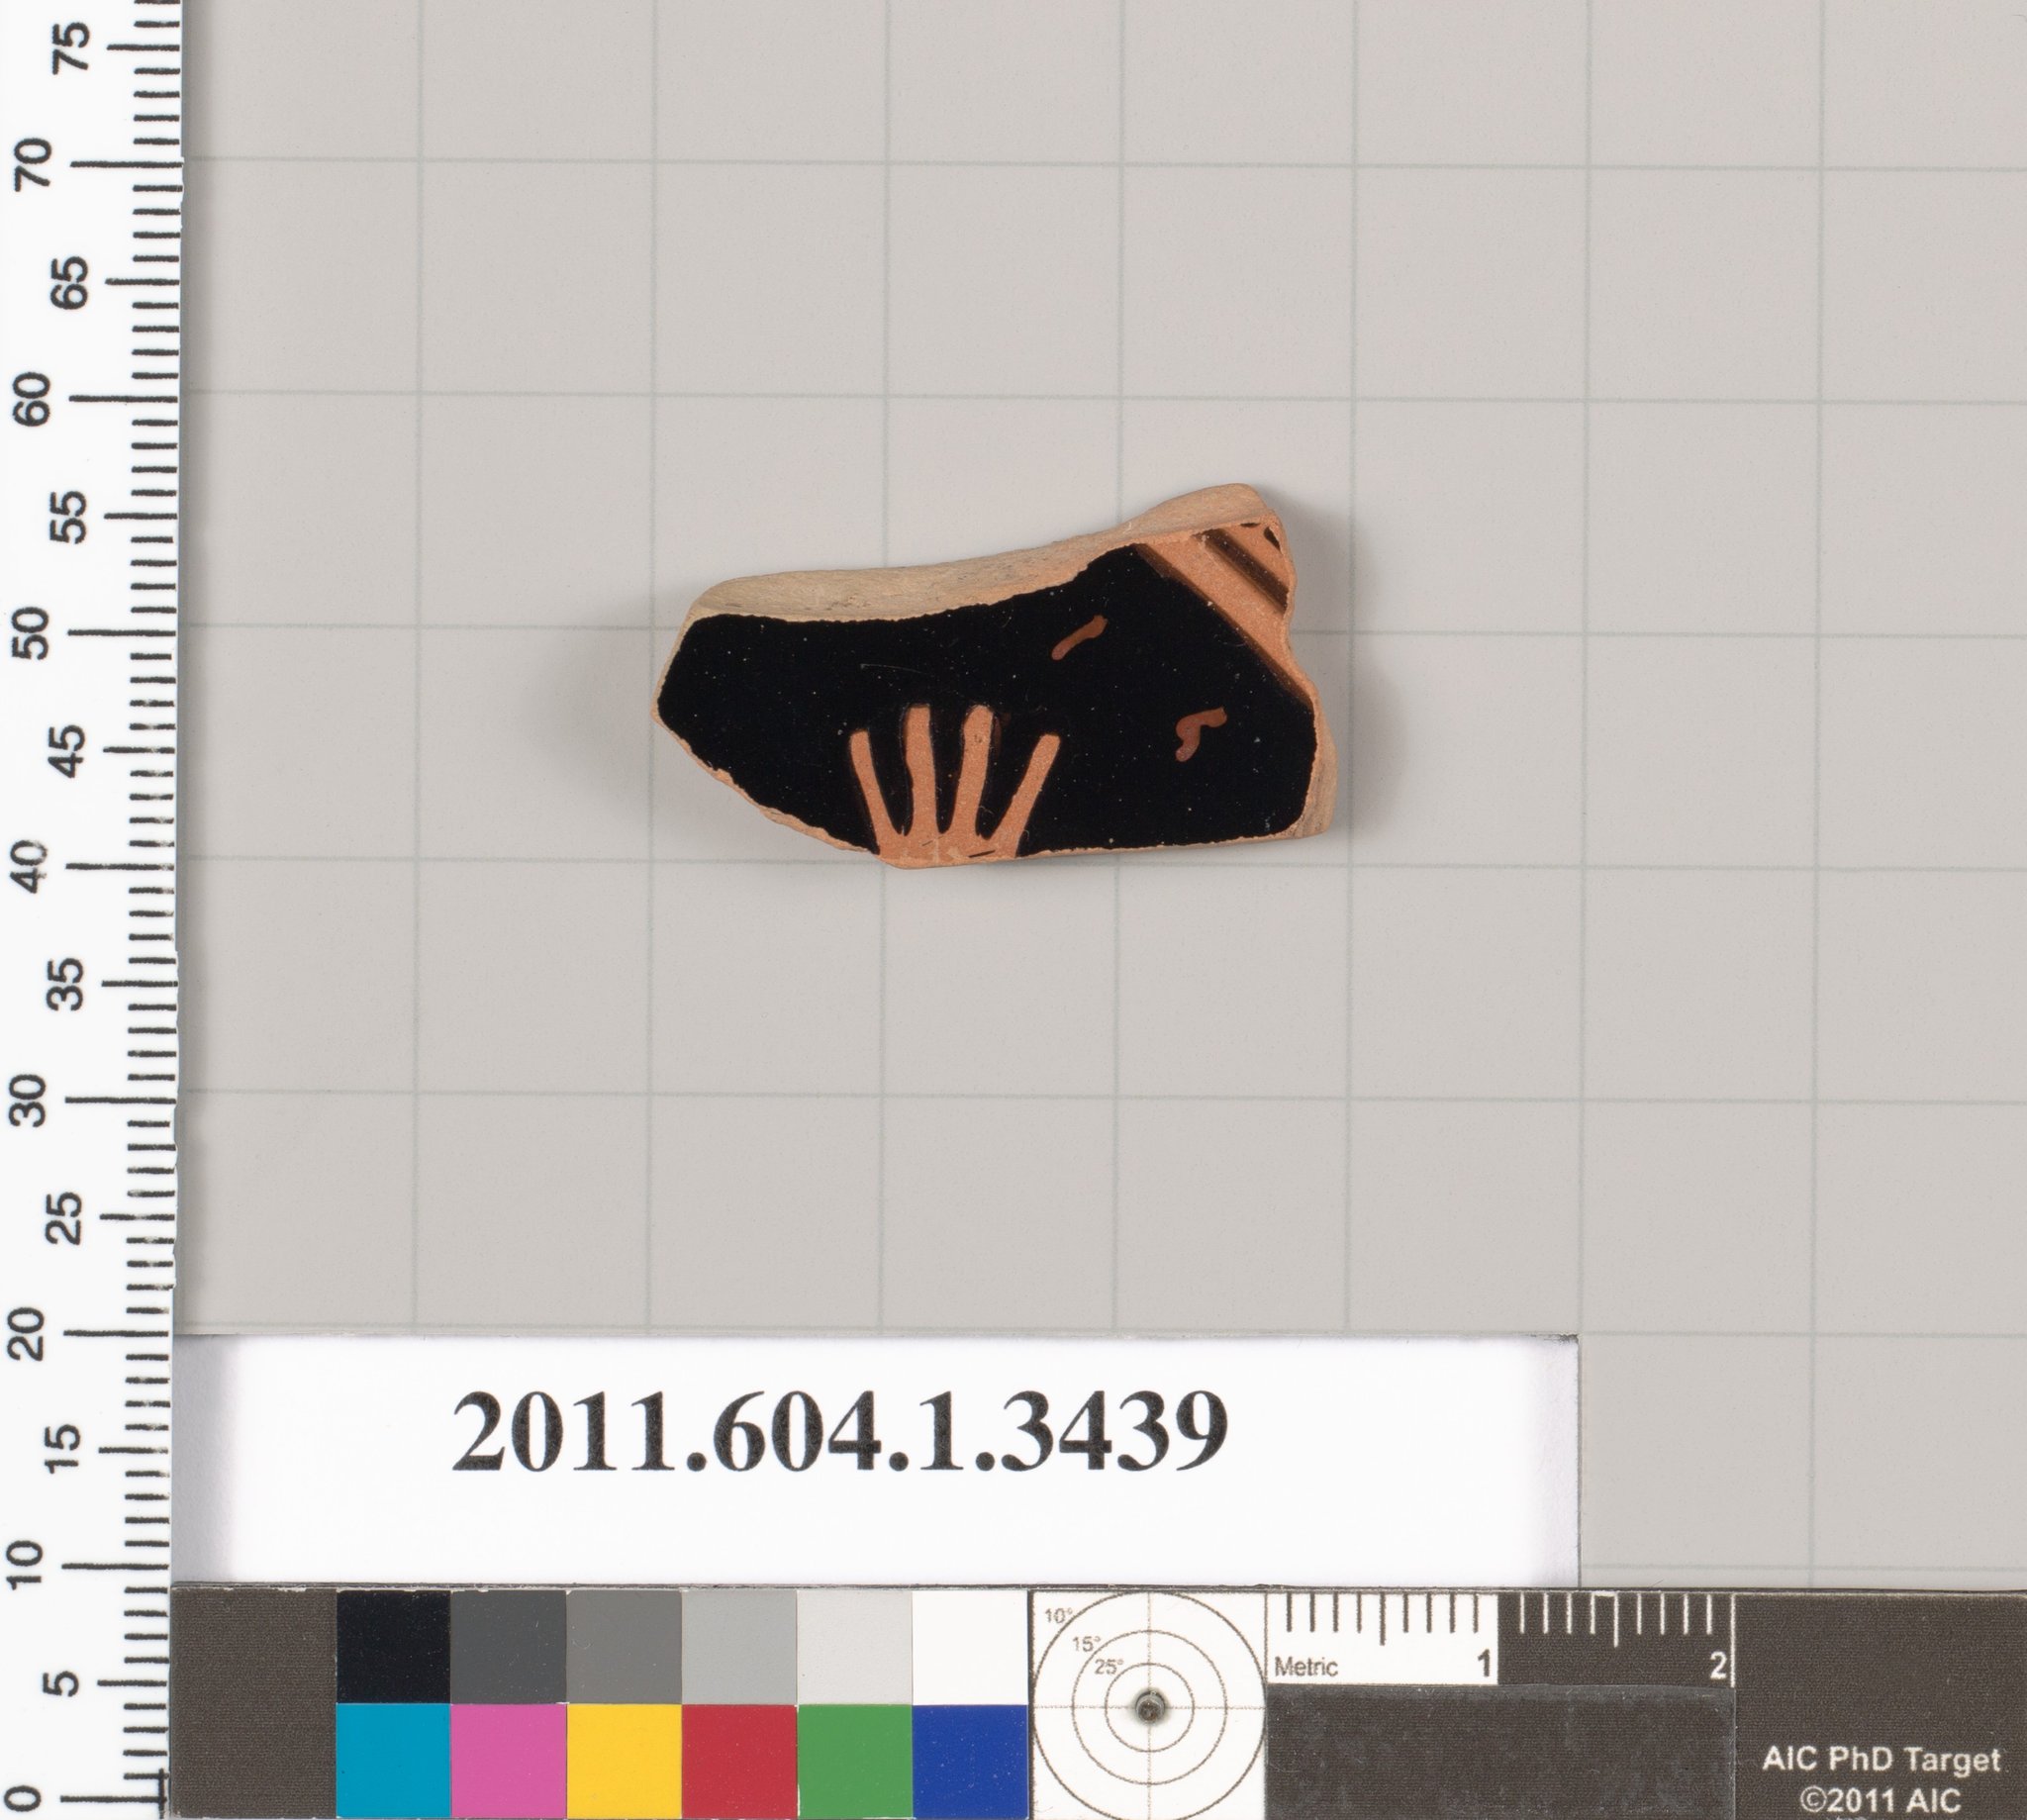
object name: kylix fragment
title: Terracotta fragment of a kylix (drinking cup)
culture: greek, attic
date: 490-470 BCE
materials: terracotta